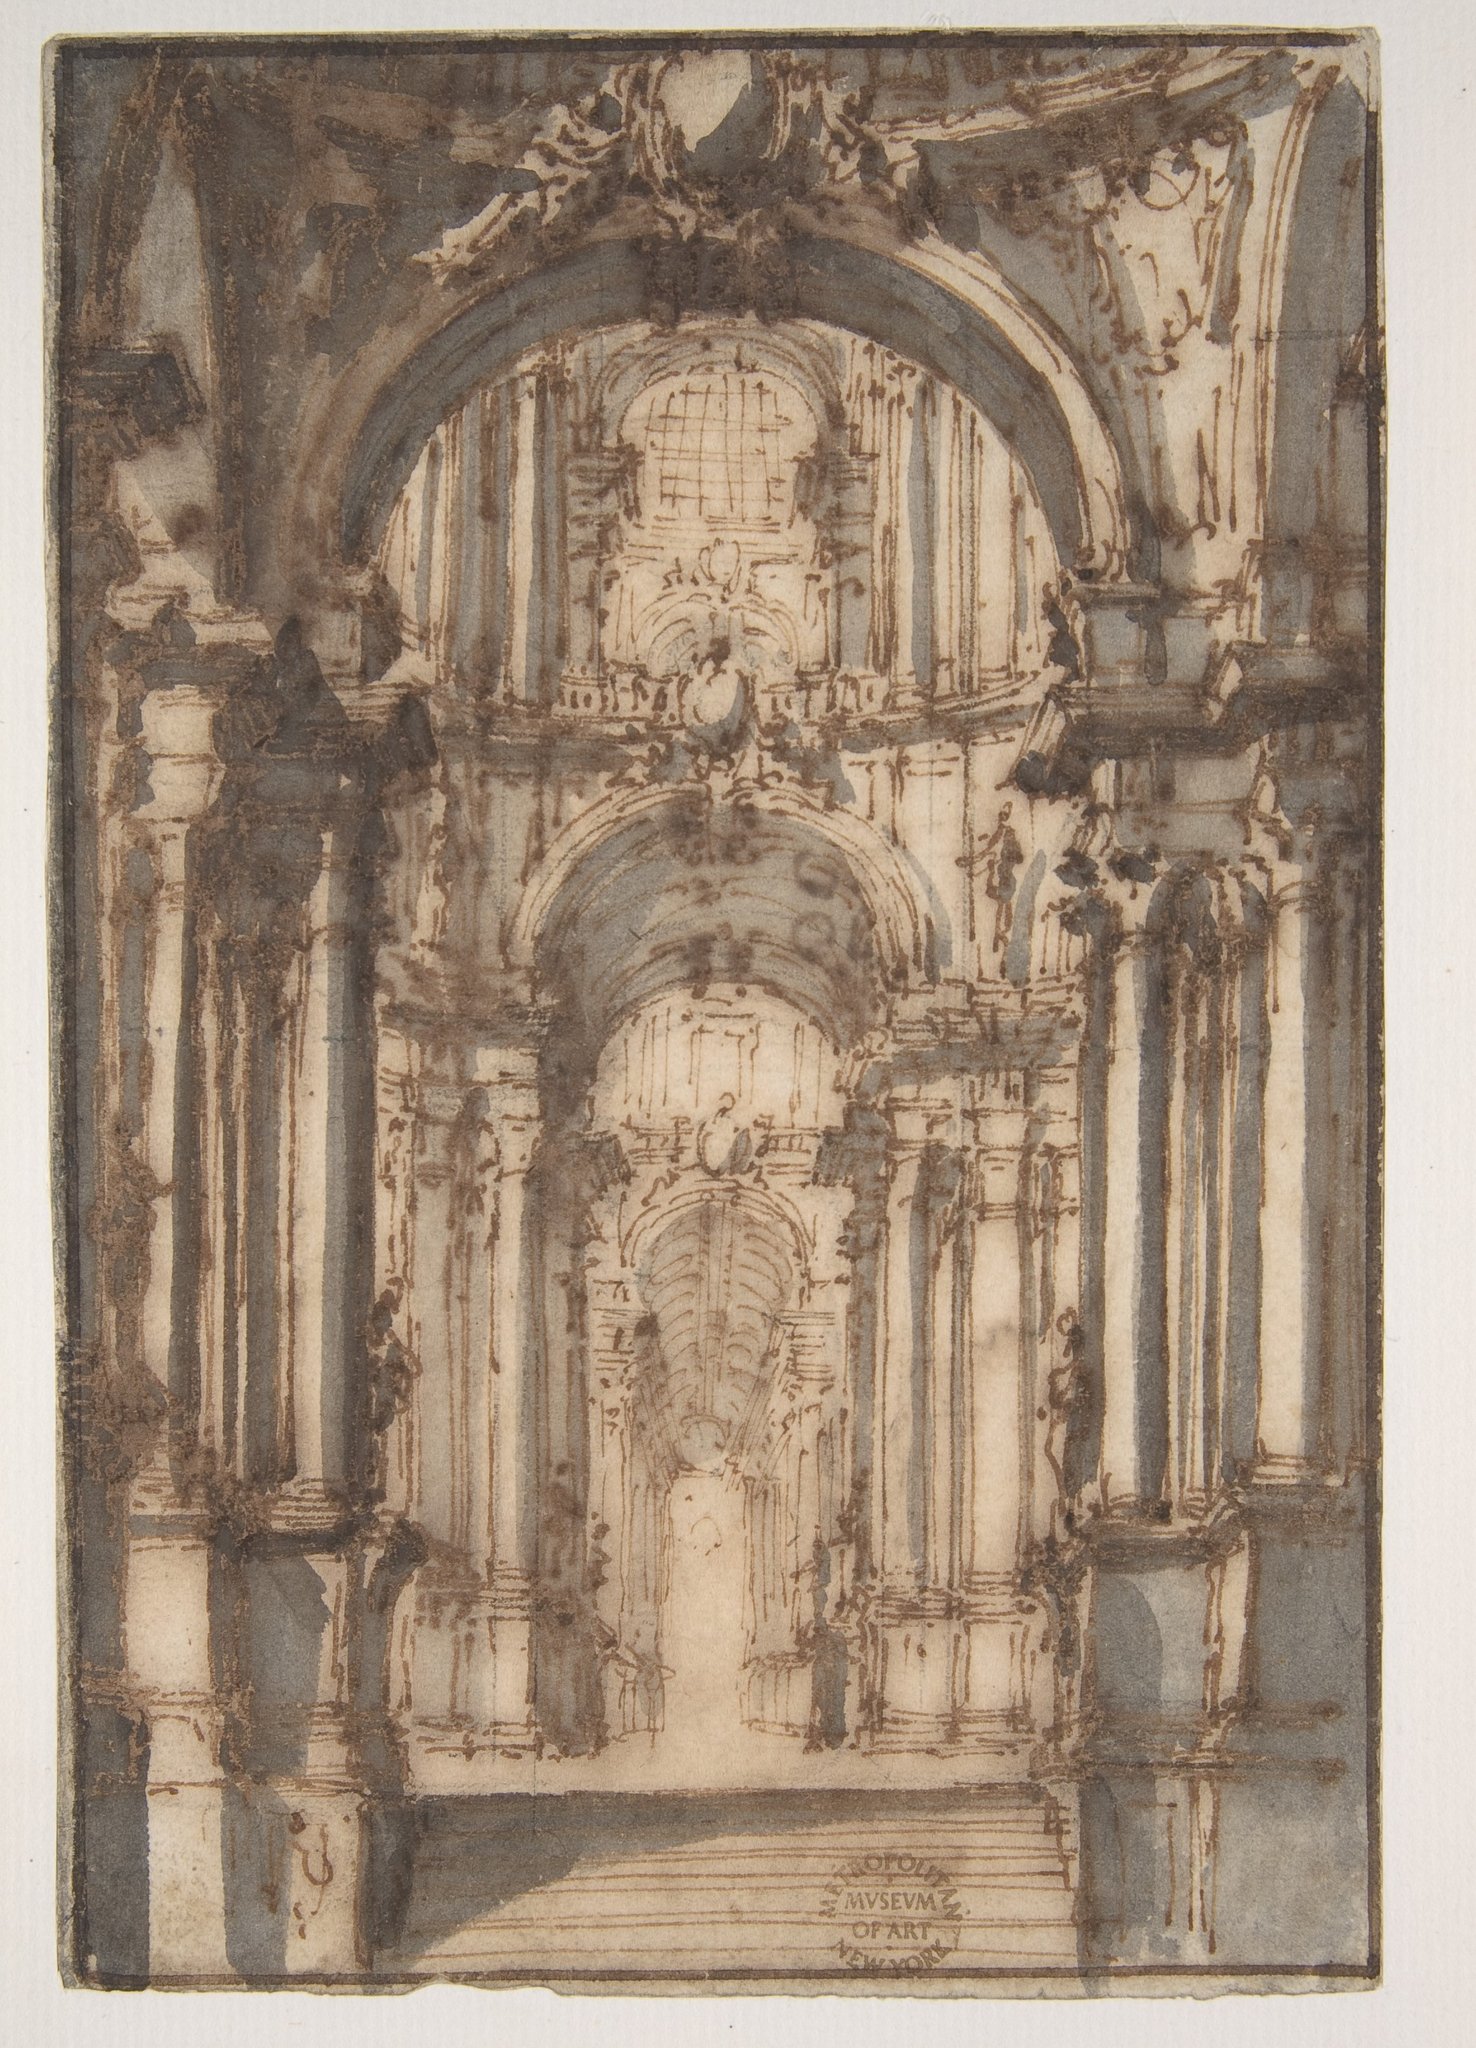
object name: drawing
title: Design for a Stage Set (recto); Fragmentary Sketch of a Plan (verso)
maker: giovanni battista natali iii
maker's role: artist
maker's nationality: italian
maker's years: 1698-1765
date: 1698-1765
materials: ink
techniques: brush, pen, wash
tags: stage design